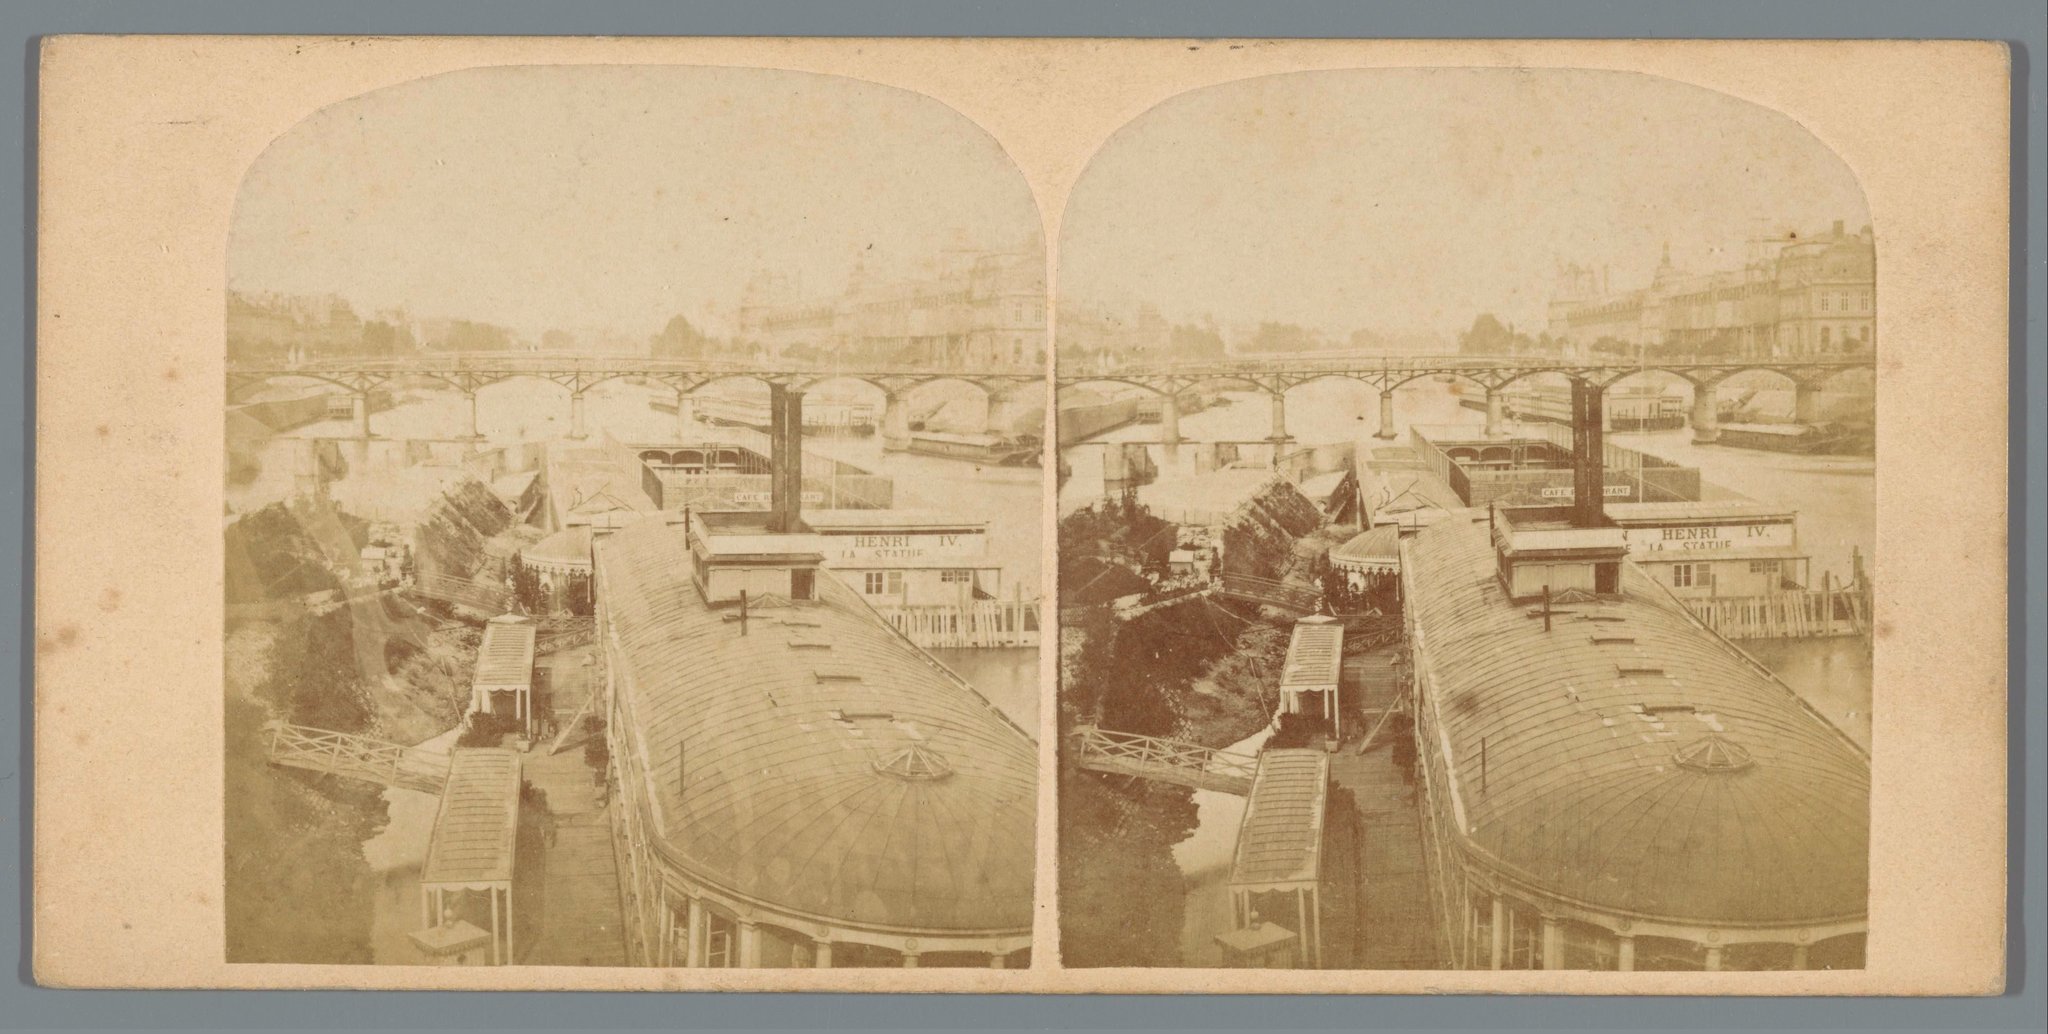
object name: stereograph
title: Gezicht over de Seine met vermoedelijk een badhuis in Parijs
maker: Anonymous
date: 1850-1880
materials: cardboard, photographic support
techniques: albumen print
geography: paris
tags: river, public baths, paris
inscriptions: inscription: ‘Pont neuf Paris’